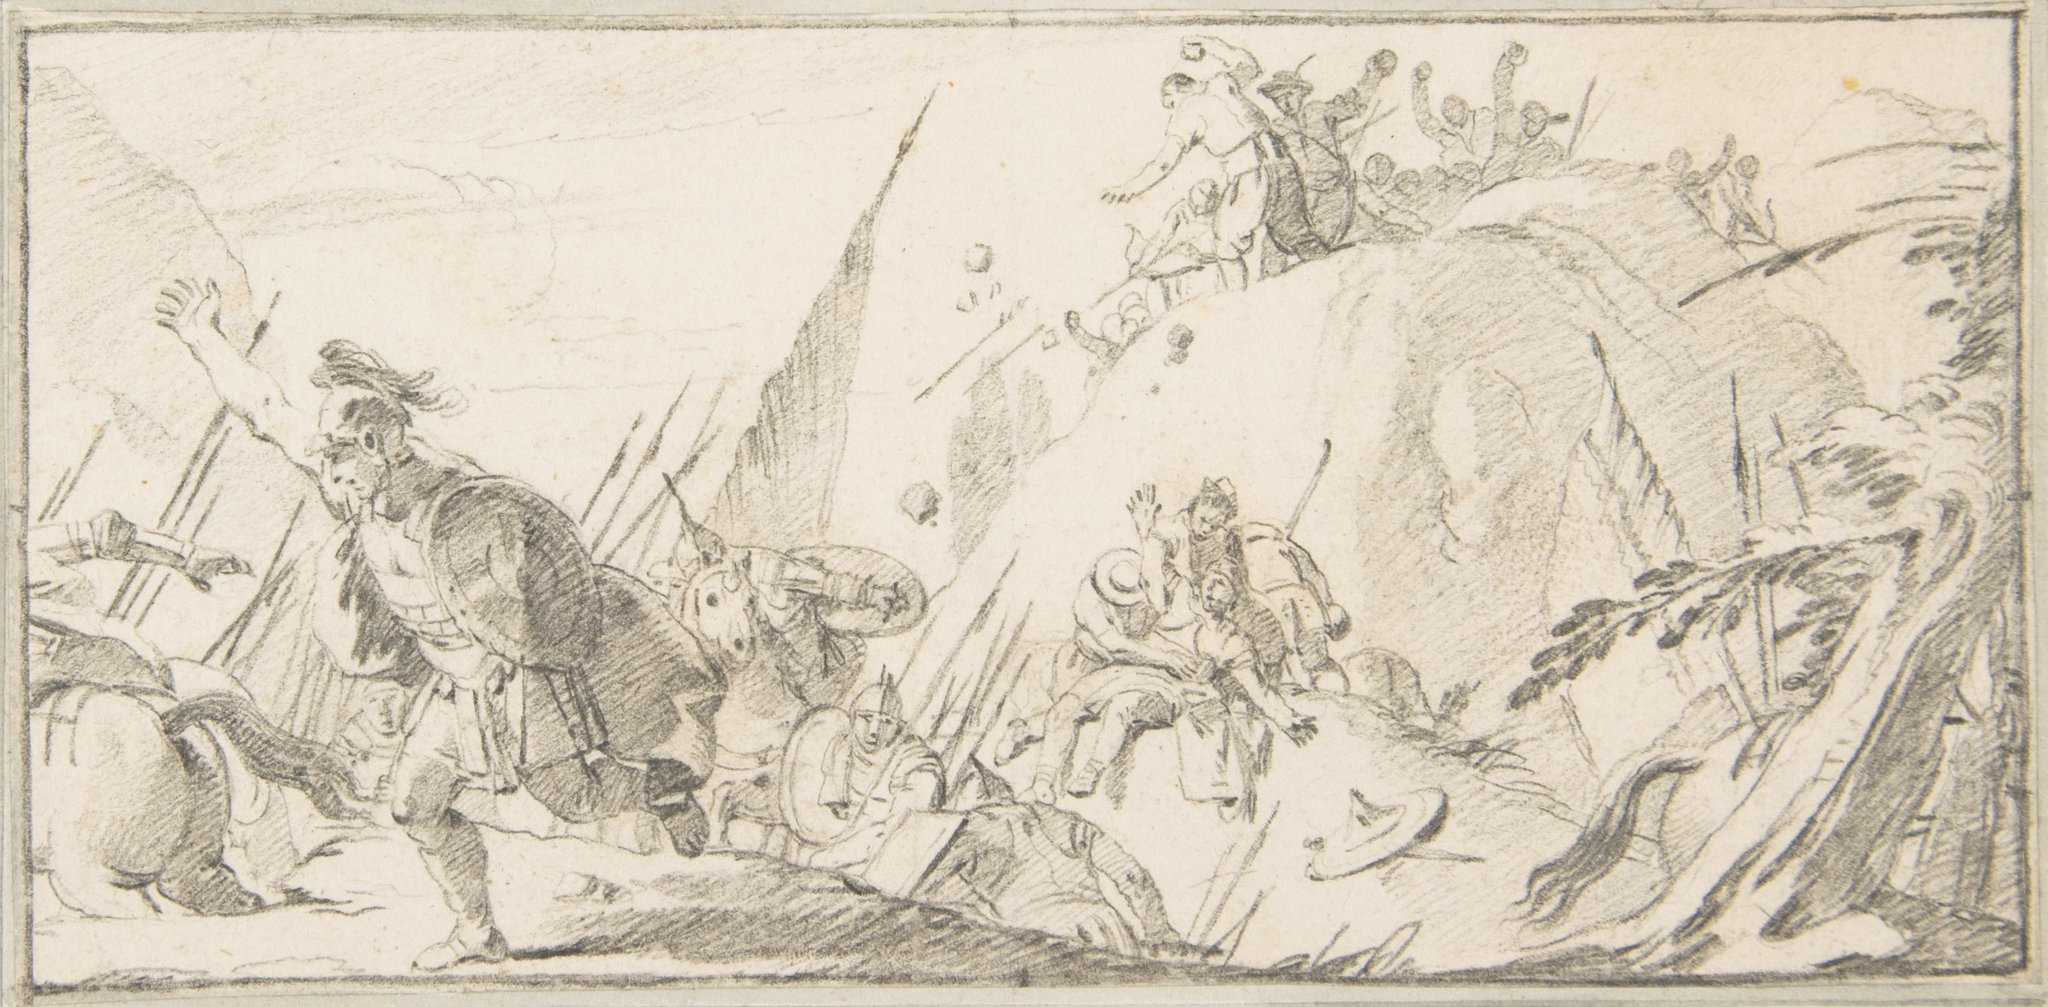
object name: drawing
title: Illustration for a Book: Scene of Combat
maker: giovanni battista tiepolo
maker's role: artist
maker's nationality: italian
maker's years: 1696-1770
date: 1696-1770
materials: chalk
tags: battles,soldiers